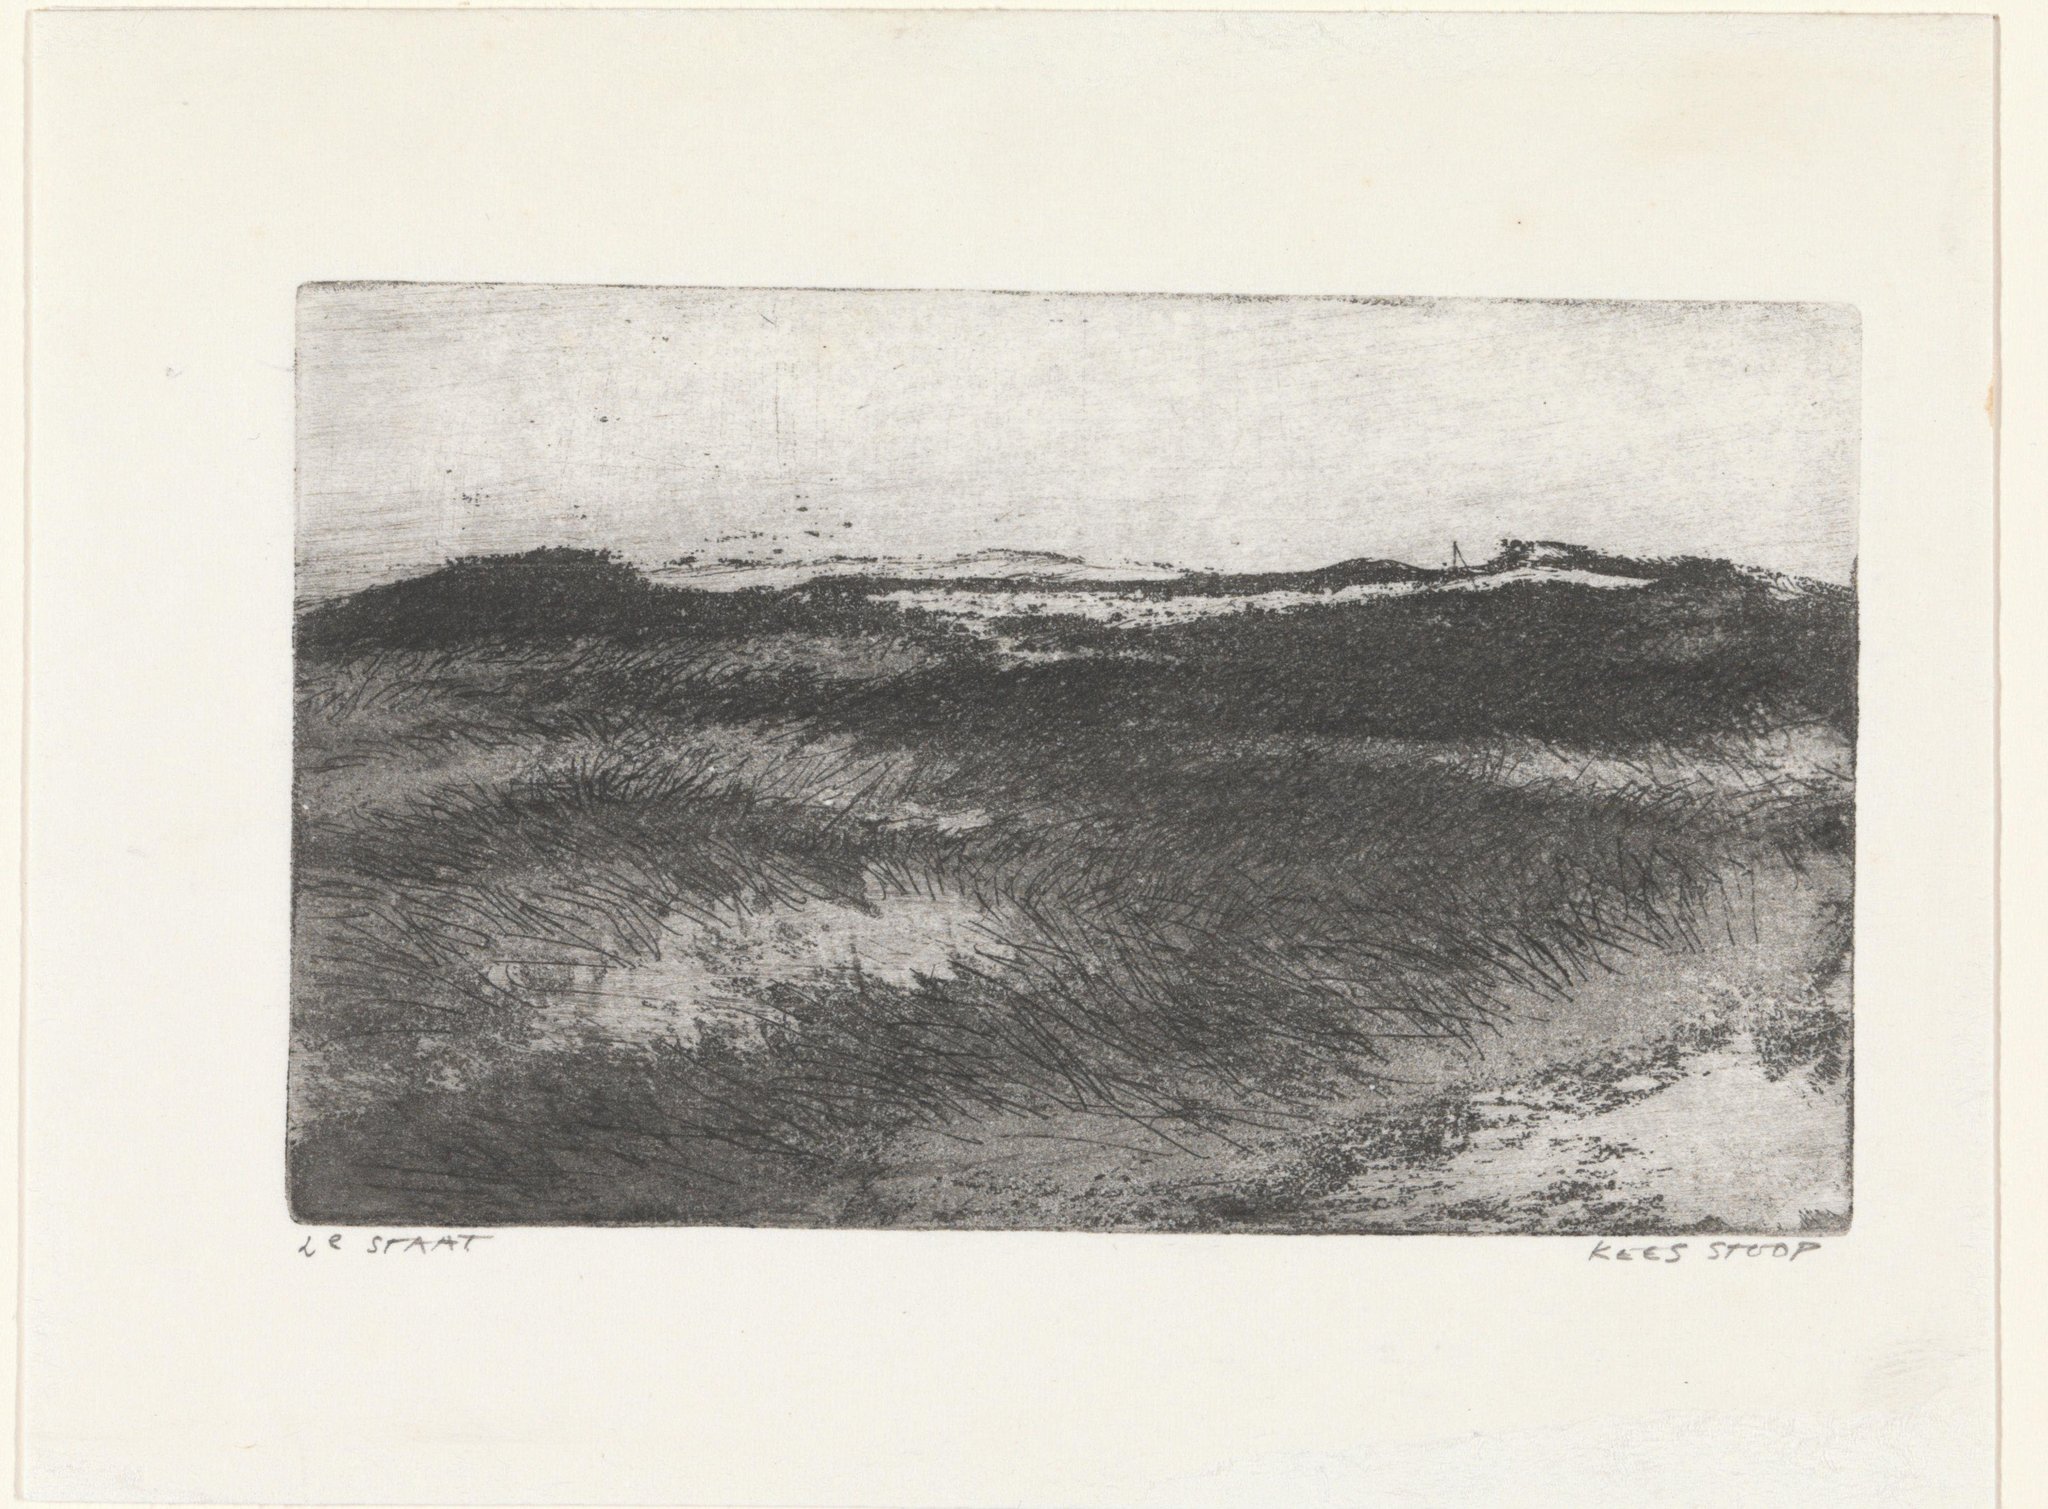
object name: print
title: Duinlandschap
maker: kees stoop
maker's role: draughtsman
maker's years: 1929-2019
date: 1944-1990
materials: paper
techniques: aquatint, drypoint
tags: dunes (sea not visible); in the dunes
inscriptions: signature and date: ‘KEES STOOP’, inscription: ‘2e STAAT’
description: Duinlandschap met helmgras, een hoge horizon.